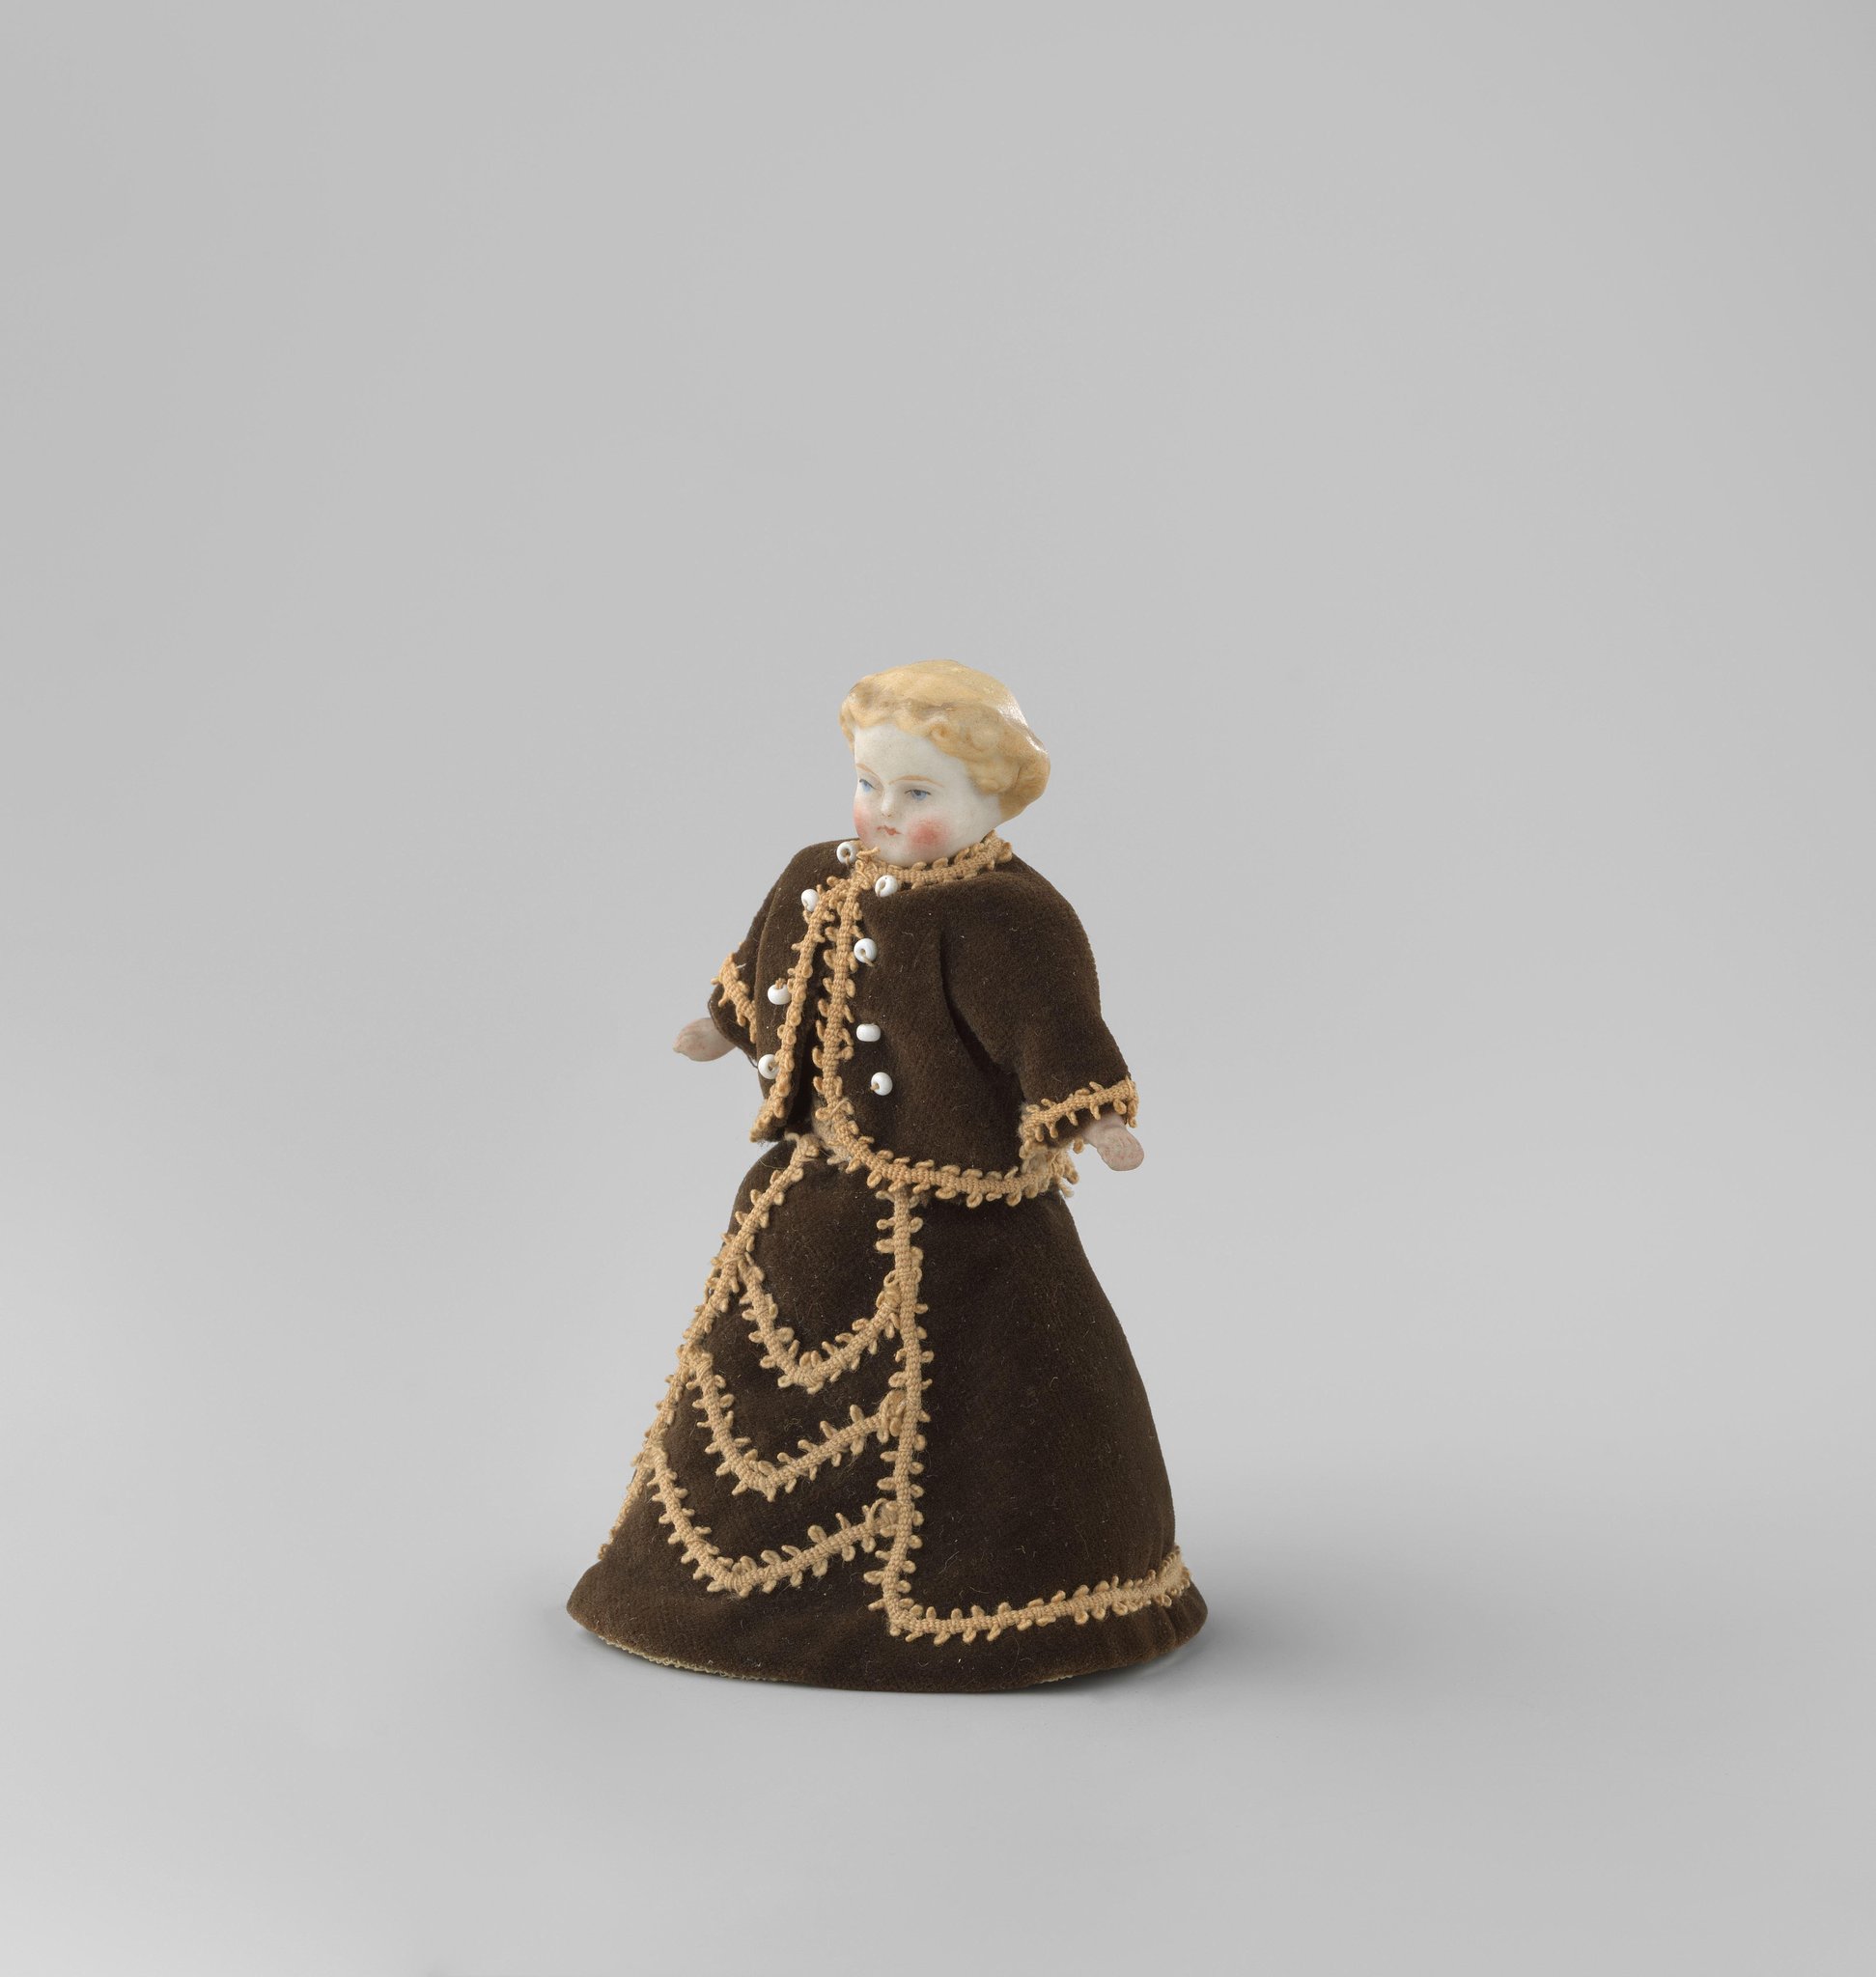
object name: doll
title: Pop van porselein met bruine japon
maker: Anonymous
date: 1850-1920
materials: porcelain, textile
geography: netherlands